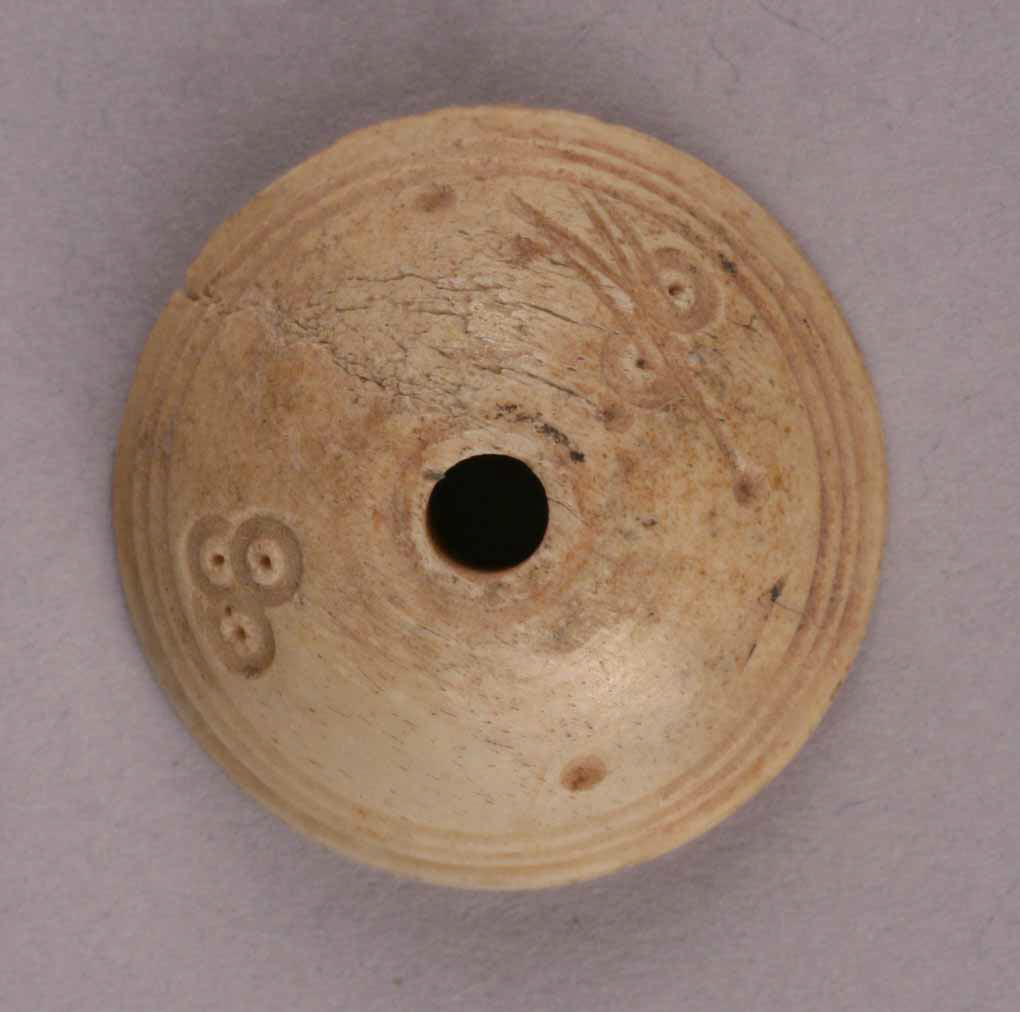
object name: spindle whorl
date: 801-1000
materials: bone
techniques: incising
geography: iran